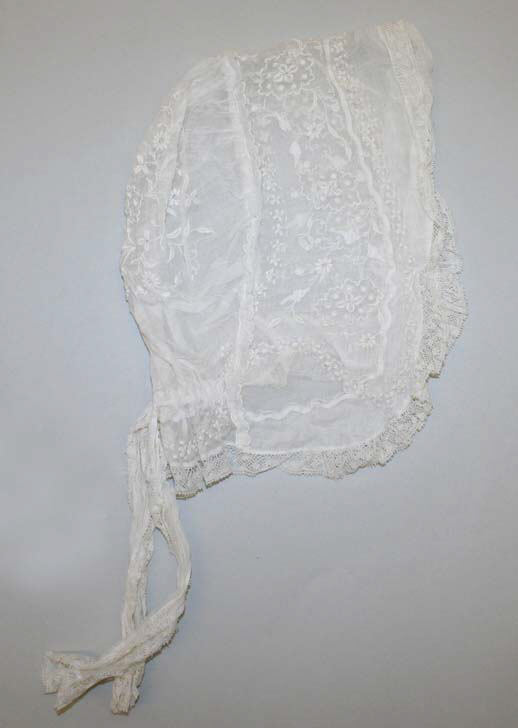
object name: bonnet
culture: american or european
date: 1801-1833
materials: cotton